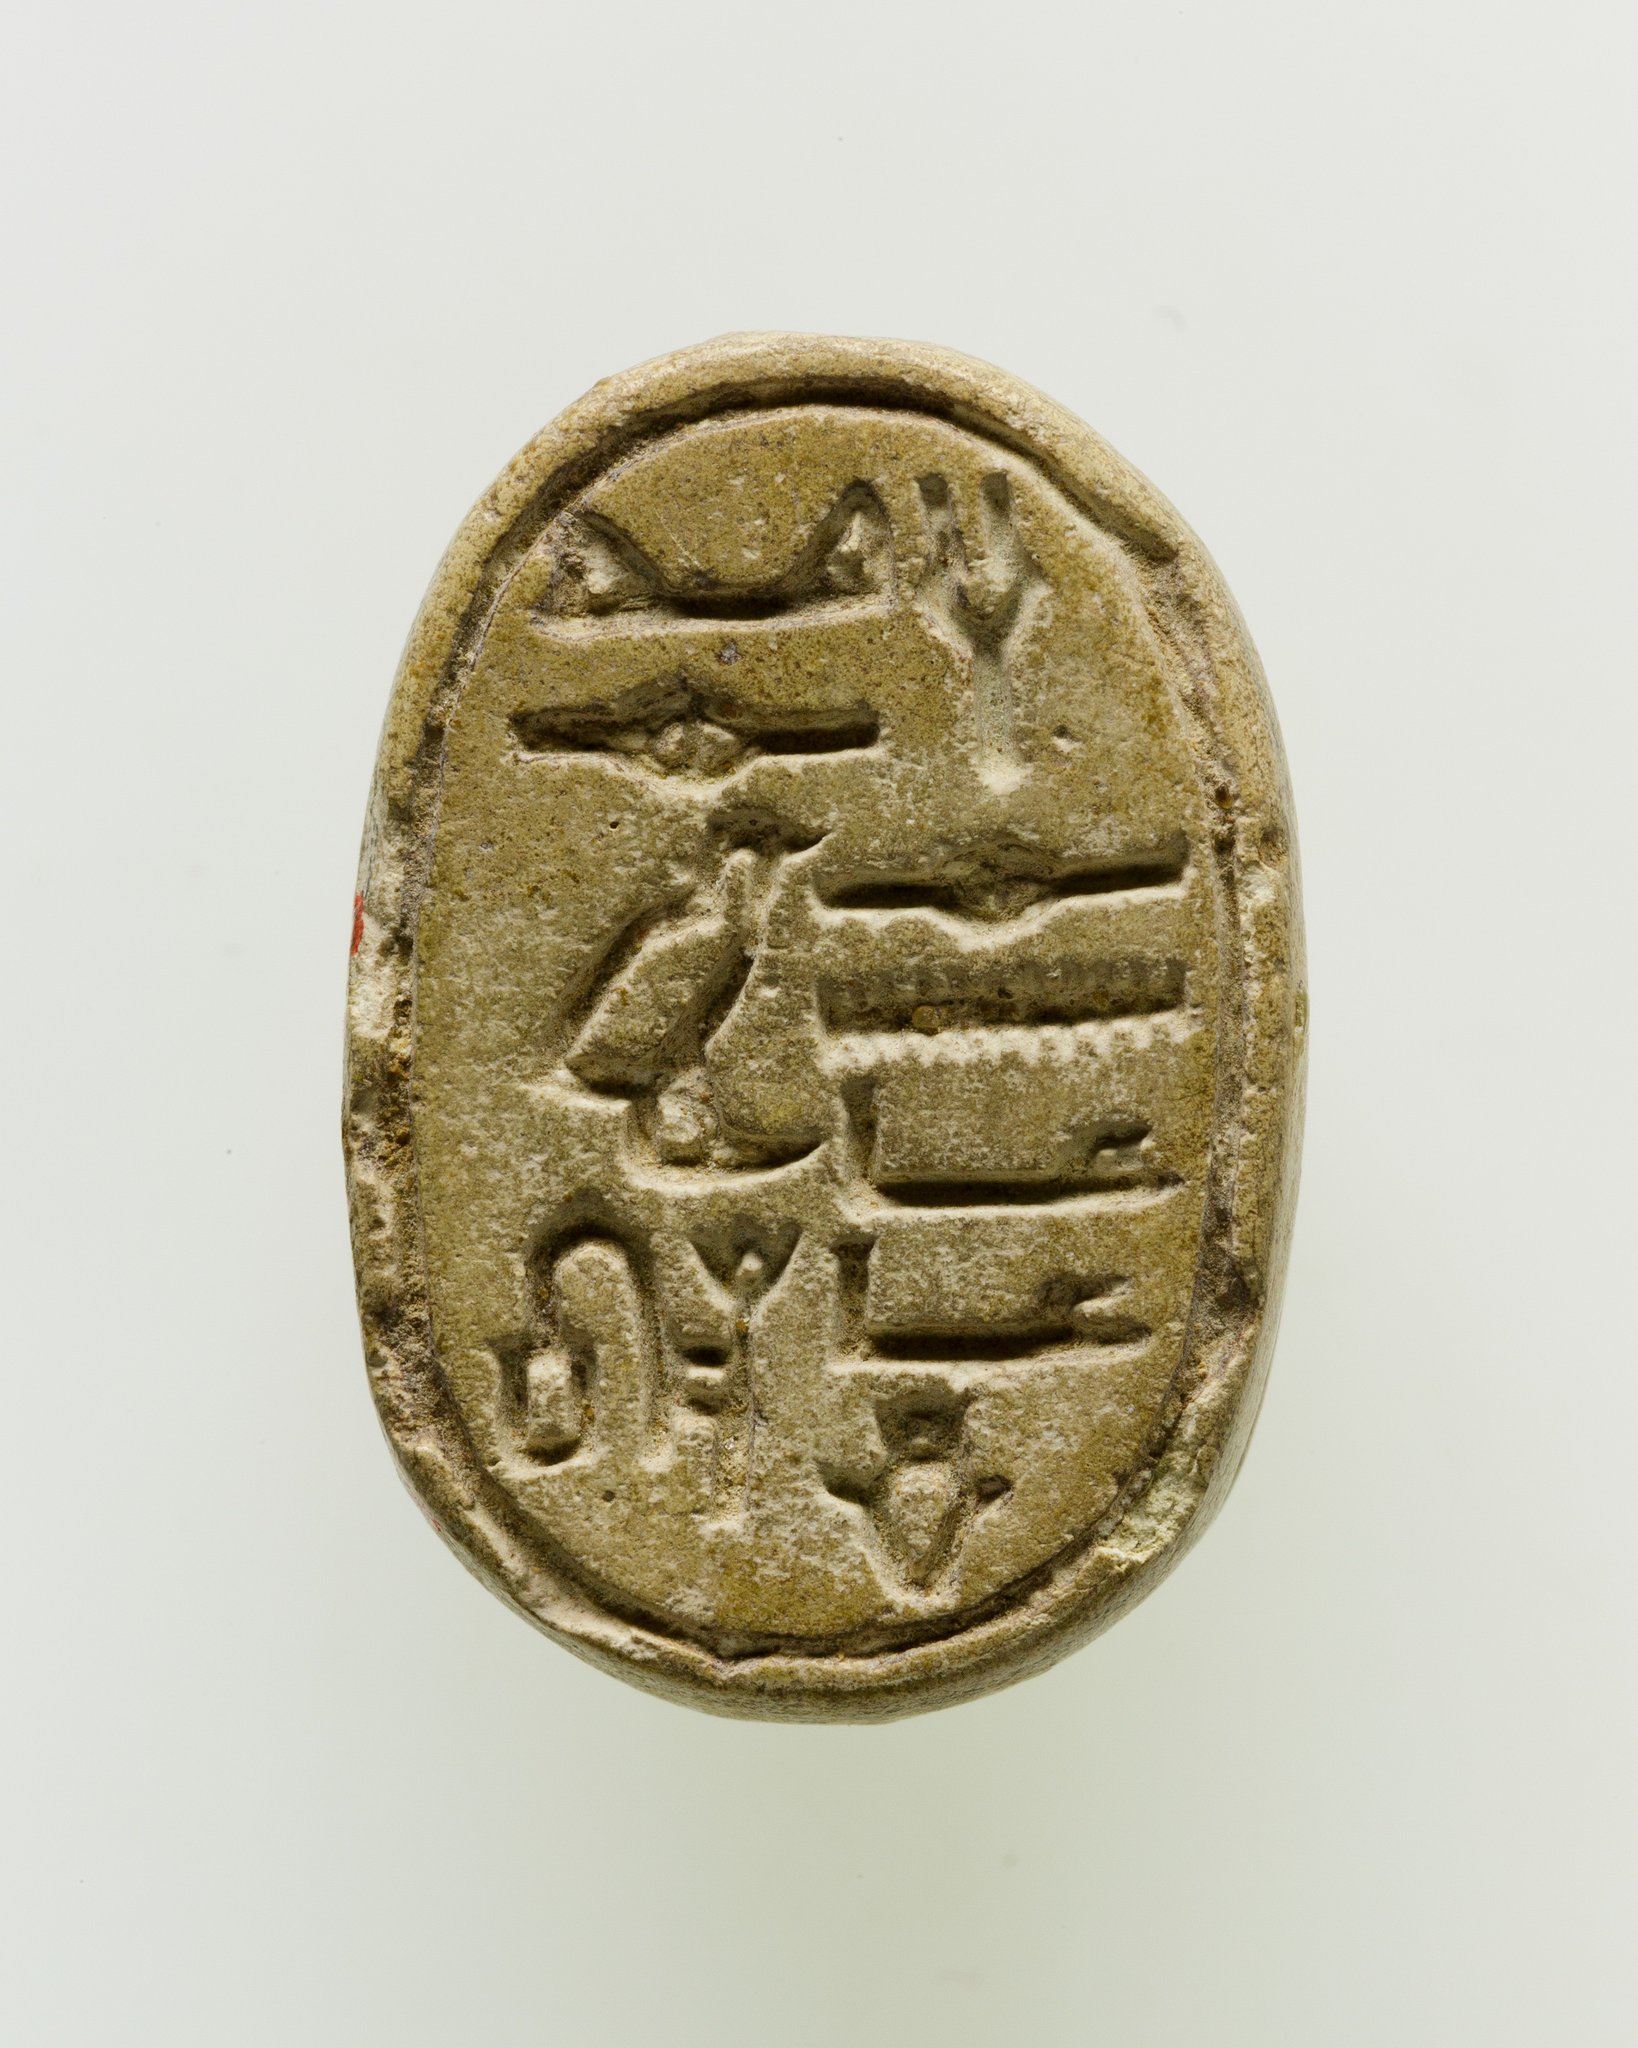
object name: scarab, official, private name and title, senaaib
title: Scarab of an Official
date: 1850-1640 BCE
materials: stone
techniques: glazing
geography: egypt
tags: hieroglyphs,scarabs